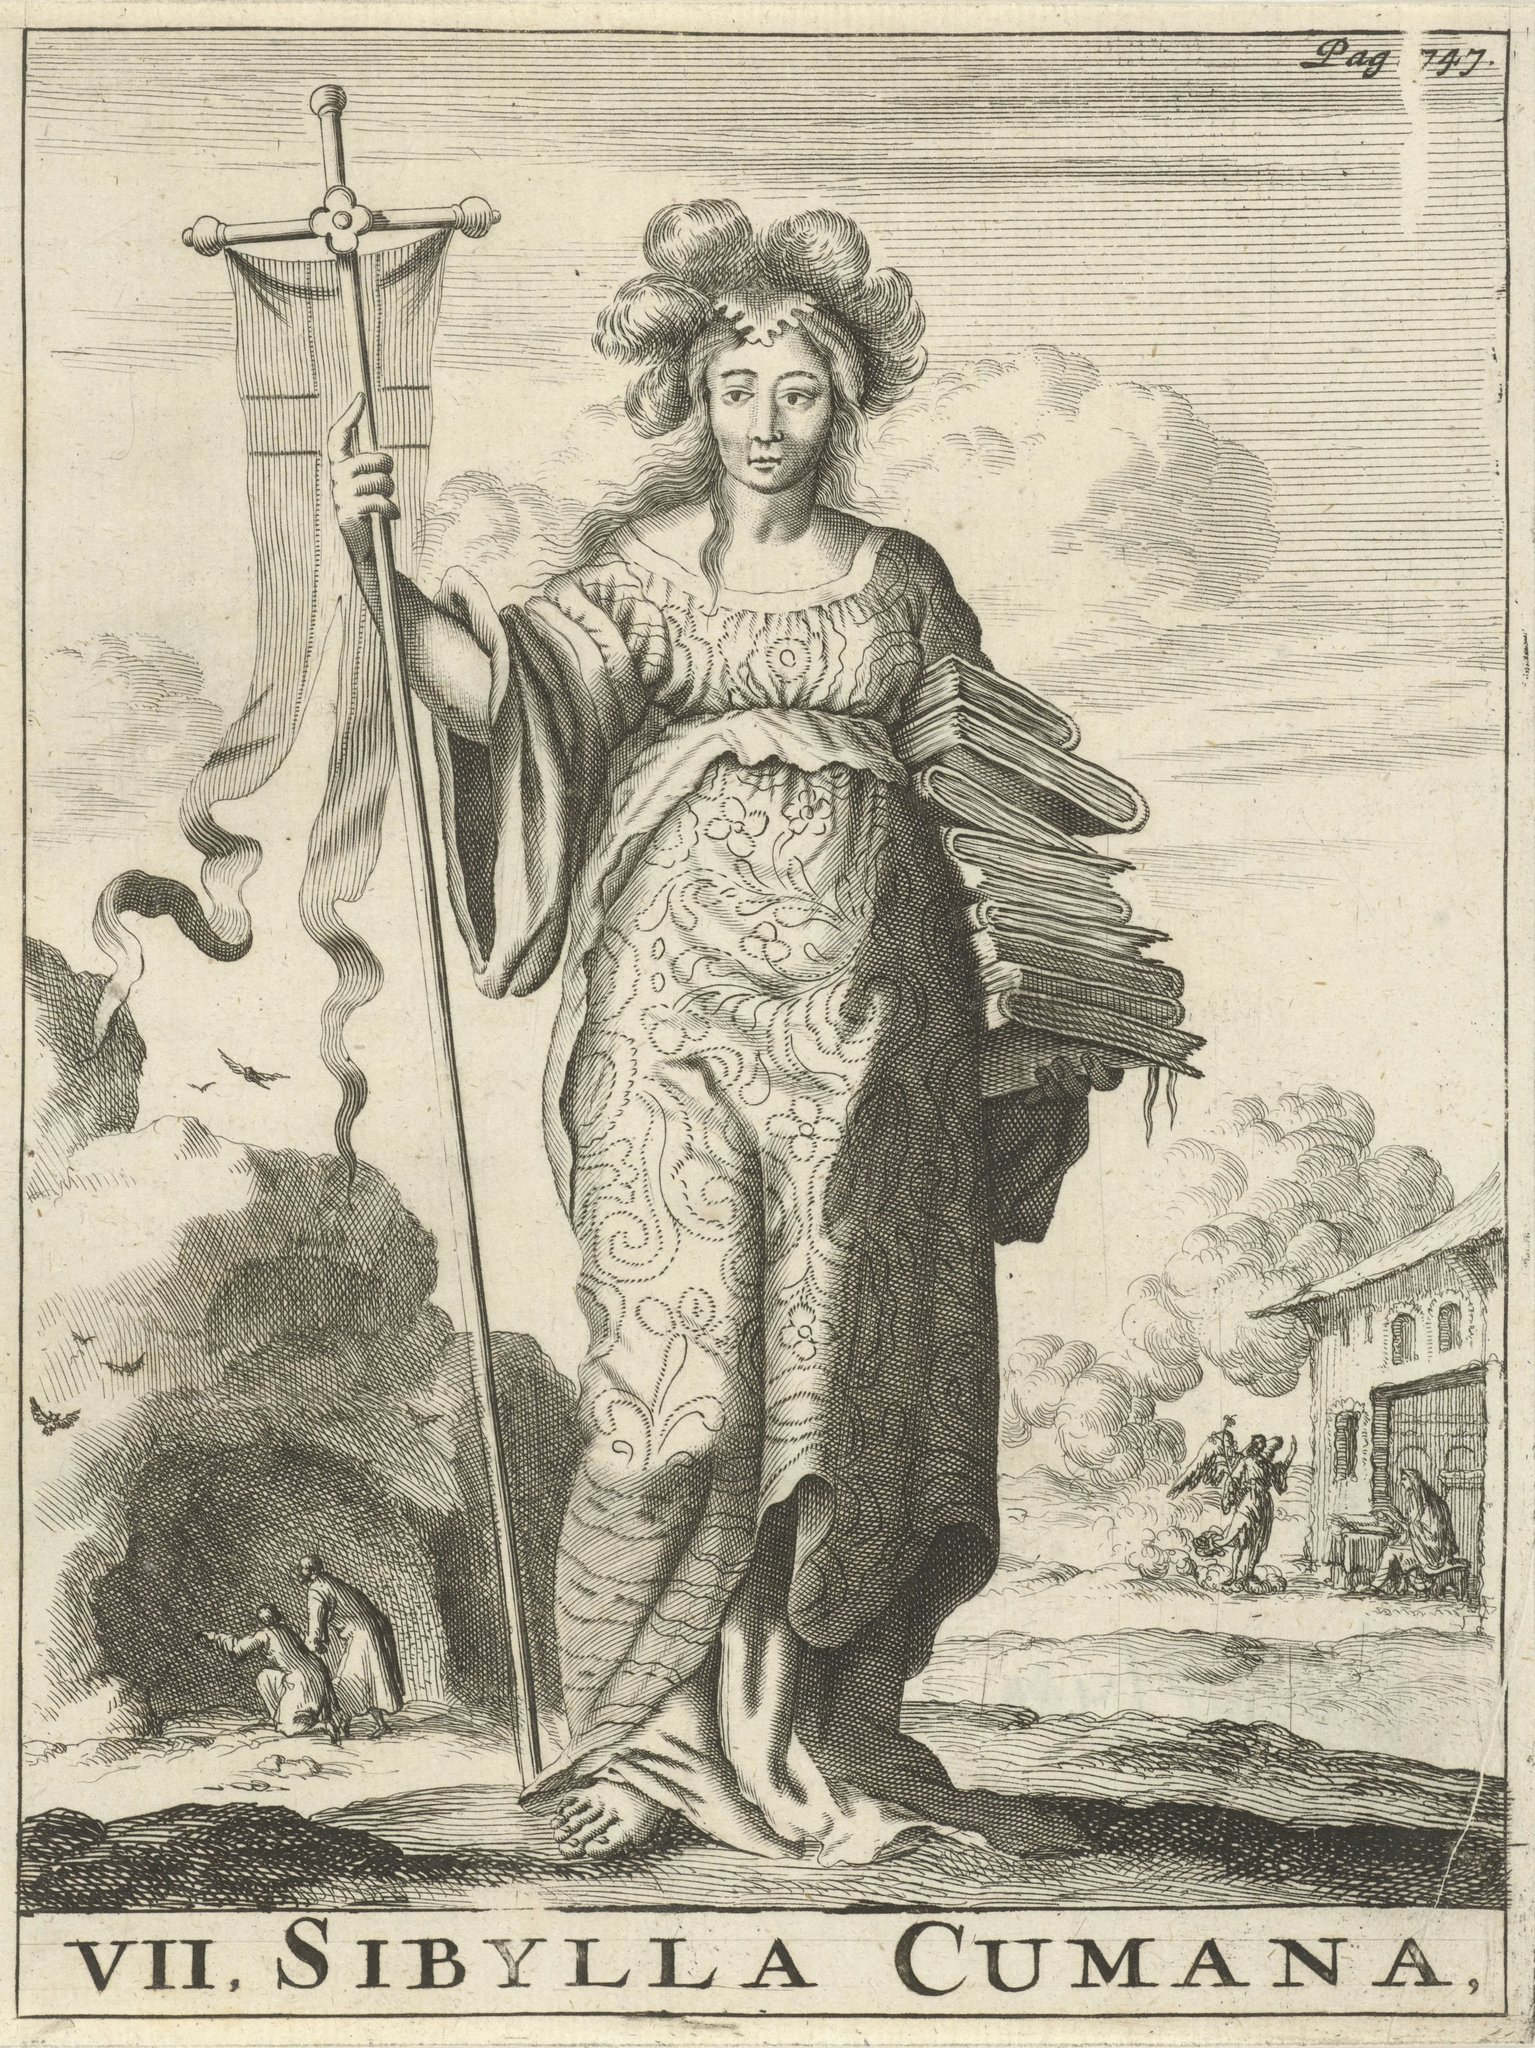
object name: print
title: Sibille van Cumae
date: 1684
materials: paper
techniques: engraving, etching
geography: amsterdam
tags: cave, grotto, the announcement of christ's birth (luke 1:26-38), cumaean sibyl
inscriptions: collector's mark: Lugt 2228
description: Sibille van Cumae. Op de achtergrond twee mannen voor de ingang van een grot en de verbeelding van de Annunciatie. Prent rechtsboven gemerkt: Pag: 747.